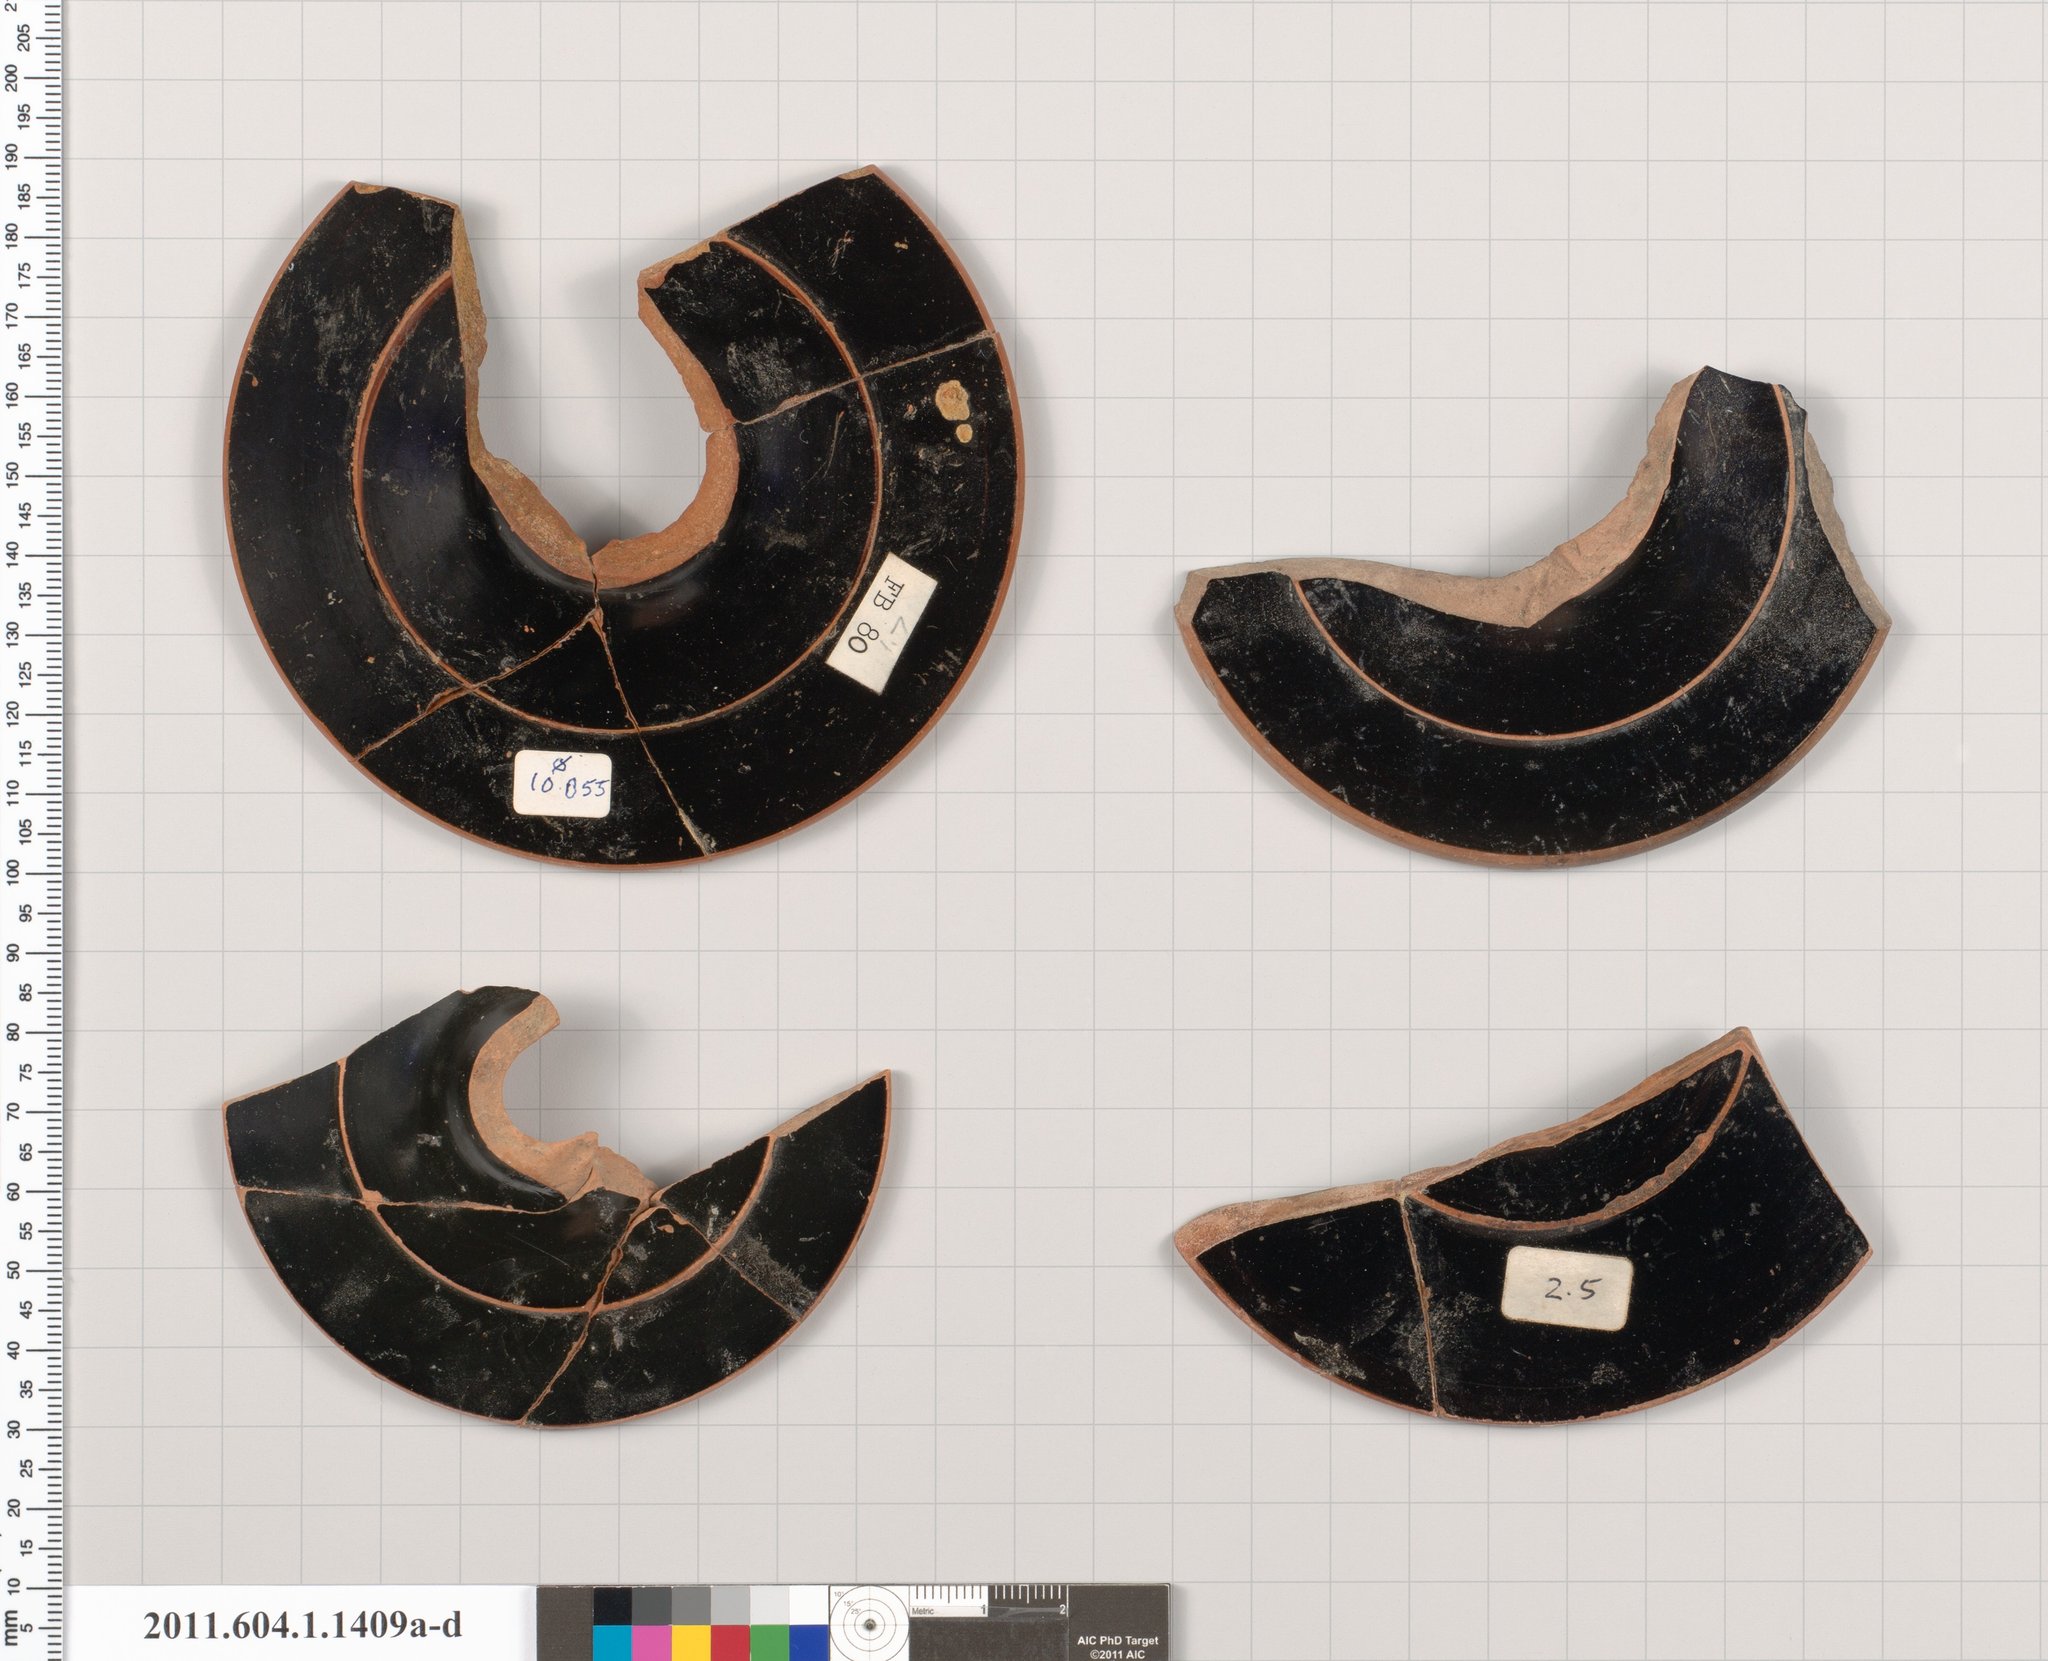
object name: kylix fragment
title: Terracotta fragments of kylikes (drinking cups)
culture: greek, attic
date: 500-401 BCE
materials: terracotta